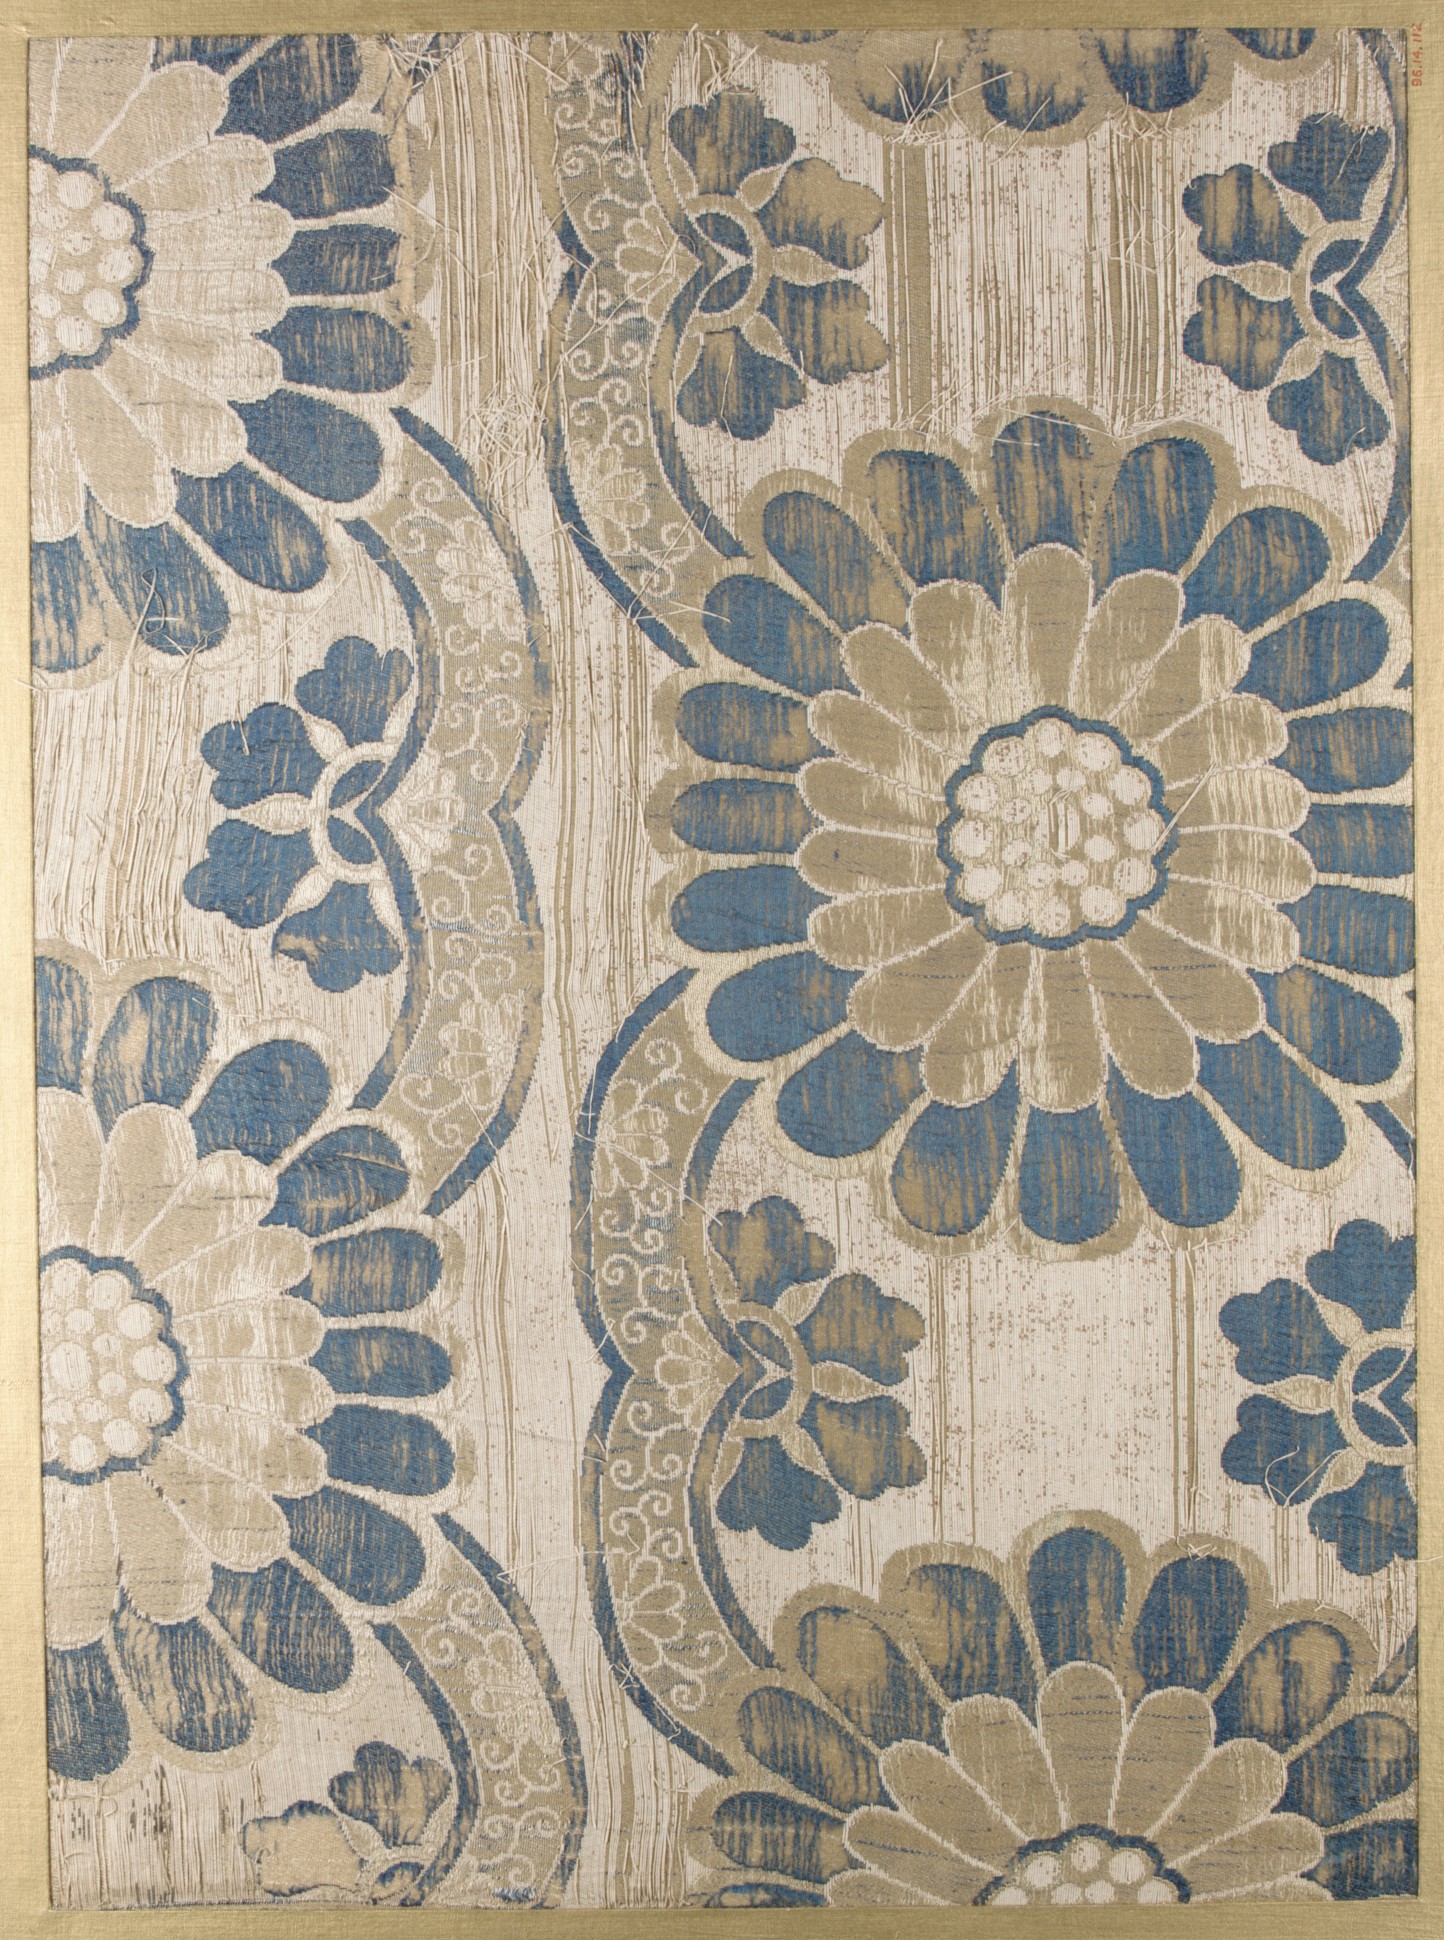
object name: piece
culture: japanese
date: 1701-1900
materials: silk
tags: flowers